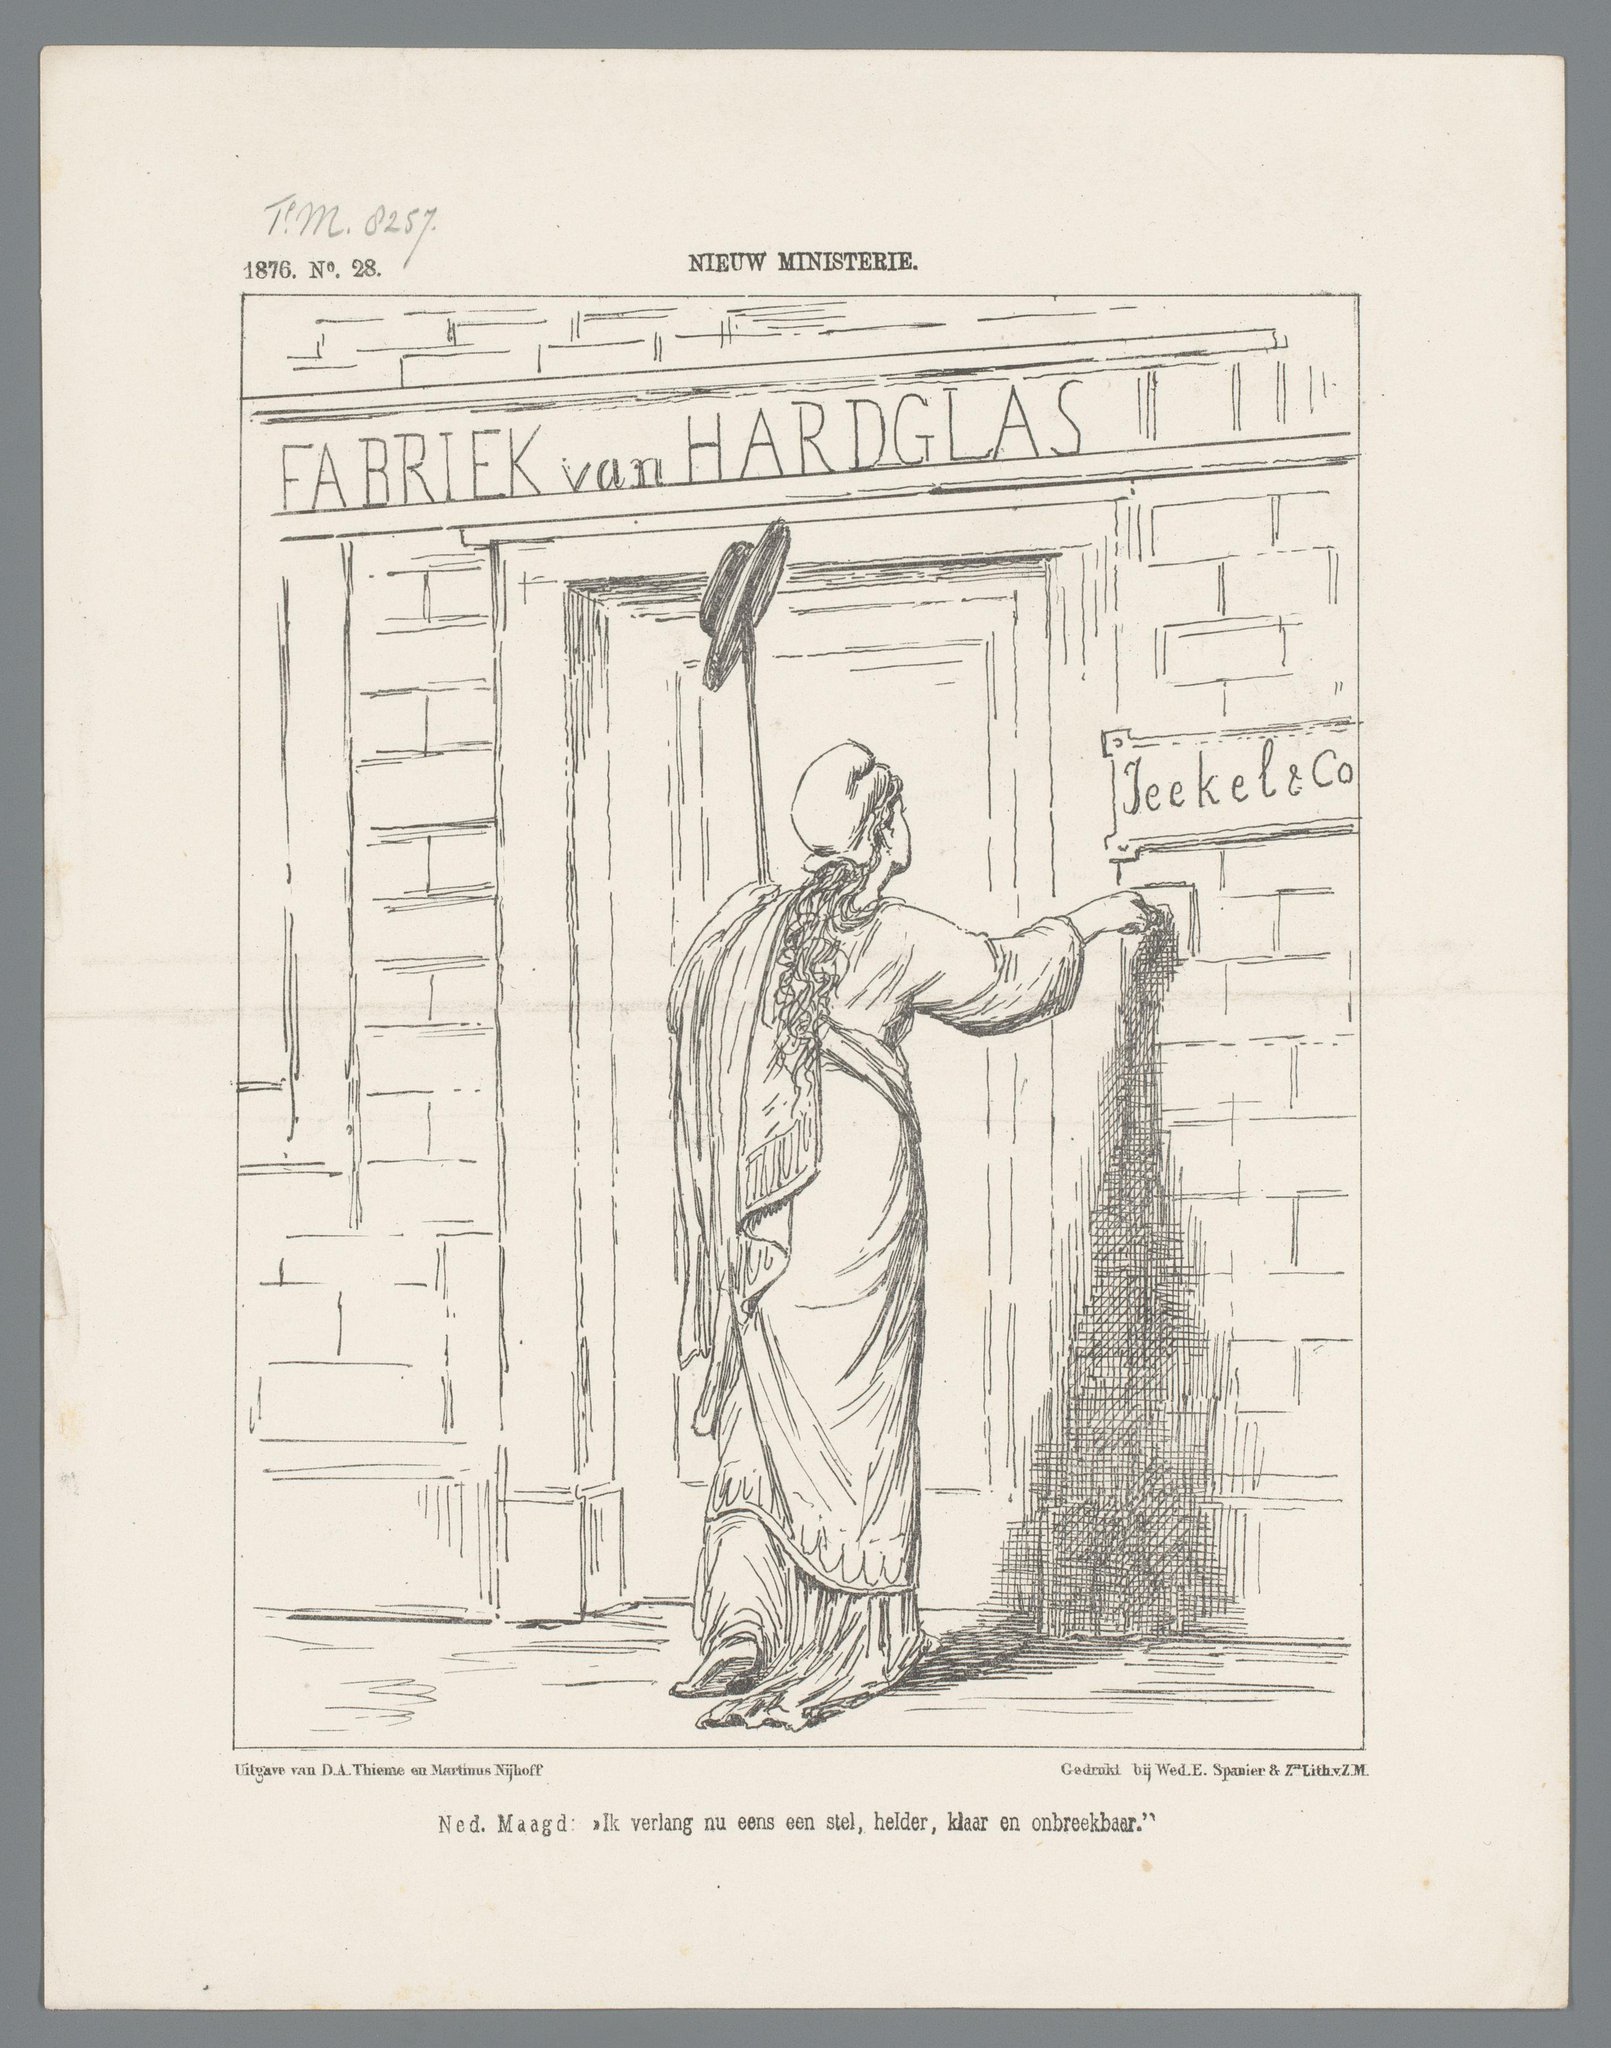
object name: print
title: Nieuw ministerie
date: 1876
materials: paper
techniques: lithograph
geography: arnhem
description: Spotprent . Plaat verschenen bij het weekblad De Nederlandsche Spectator, nr. 28, 1876.